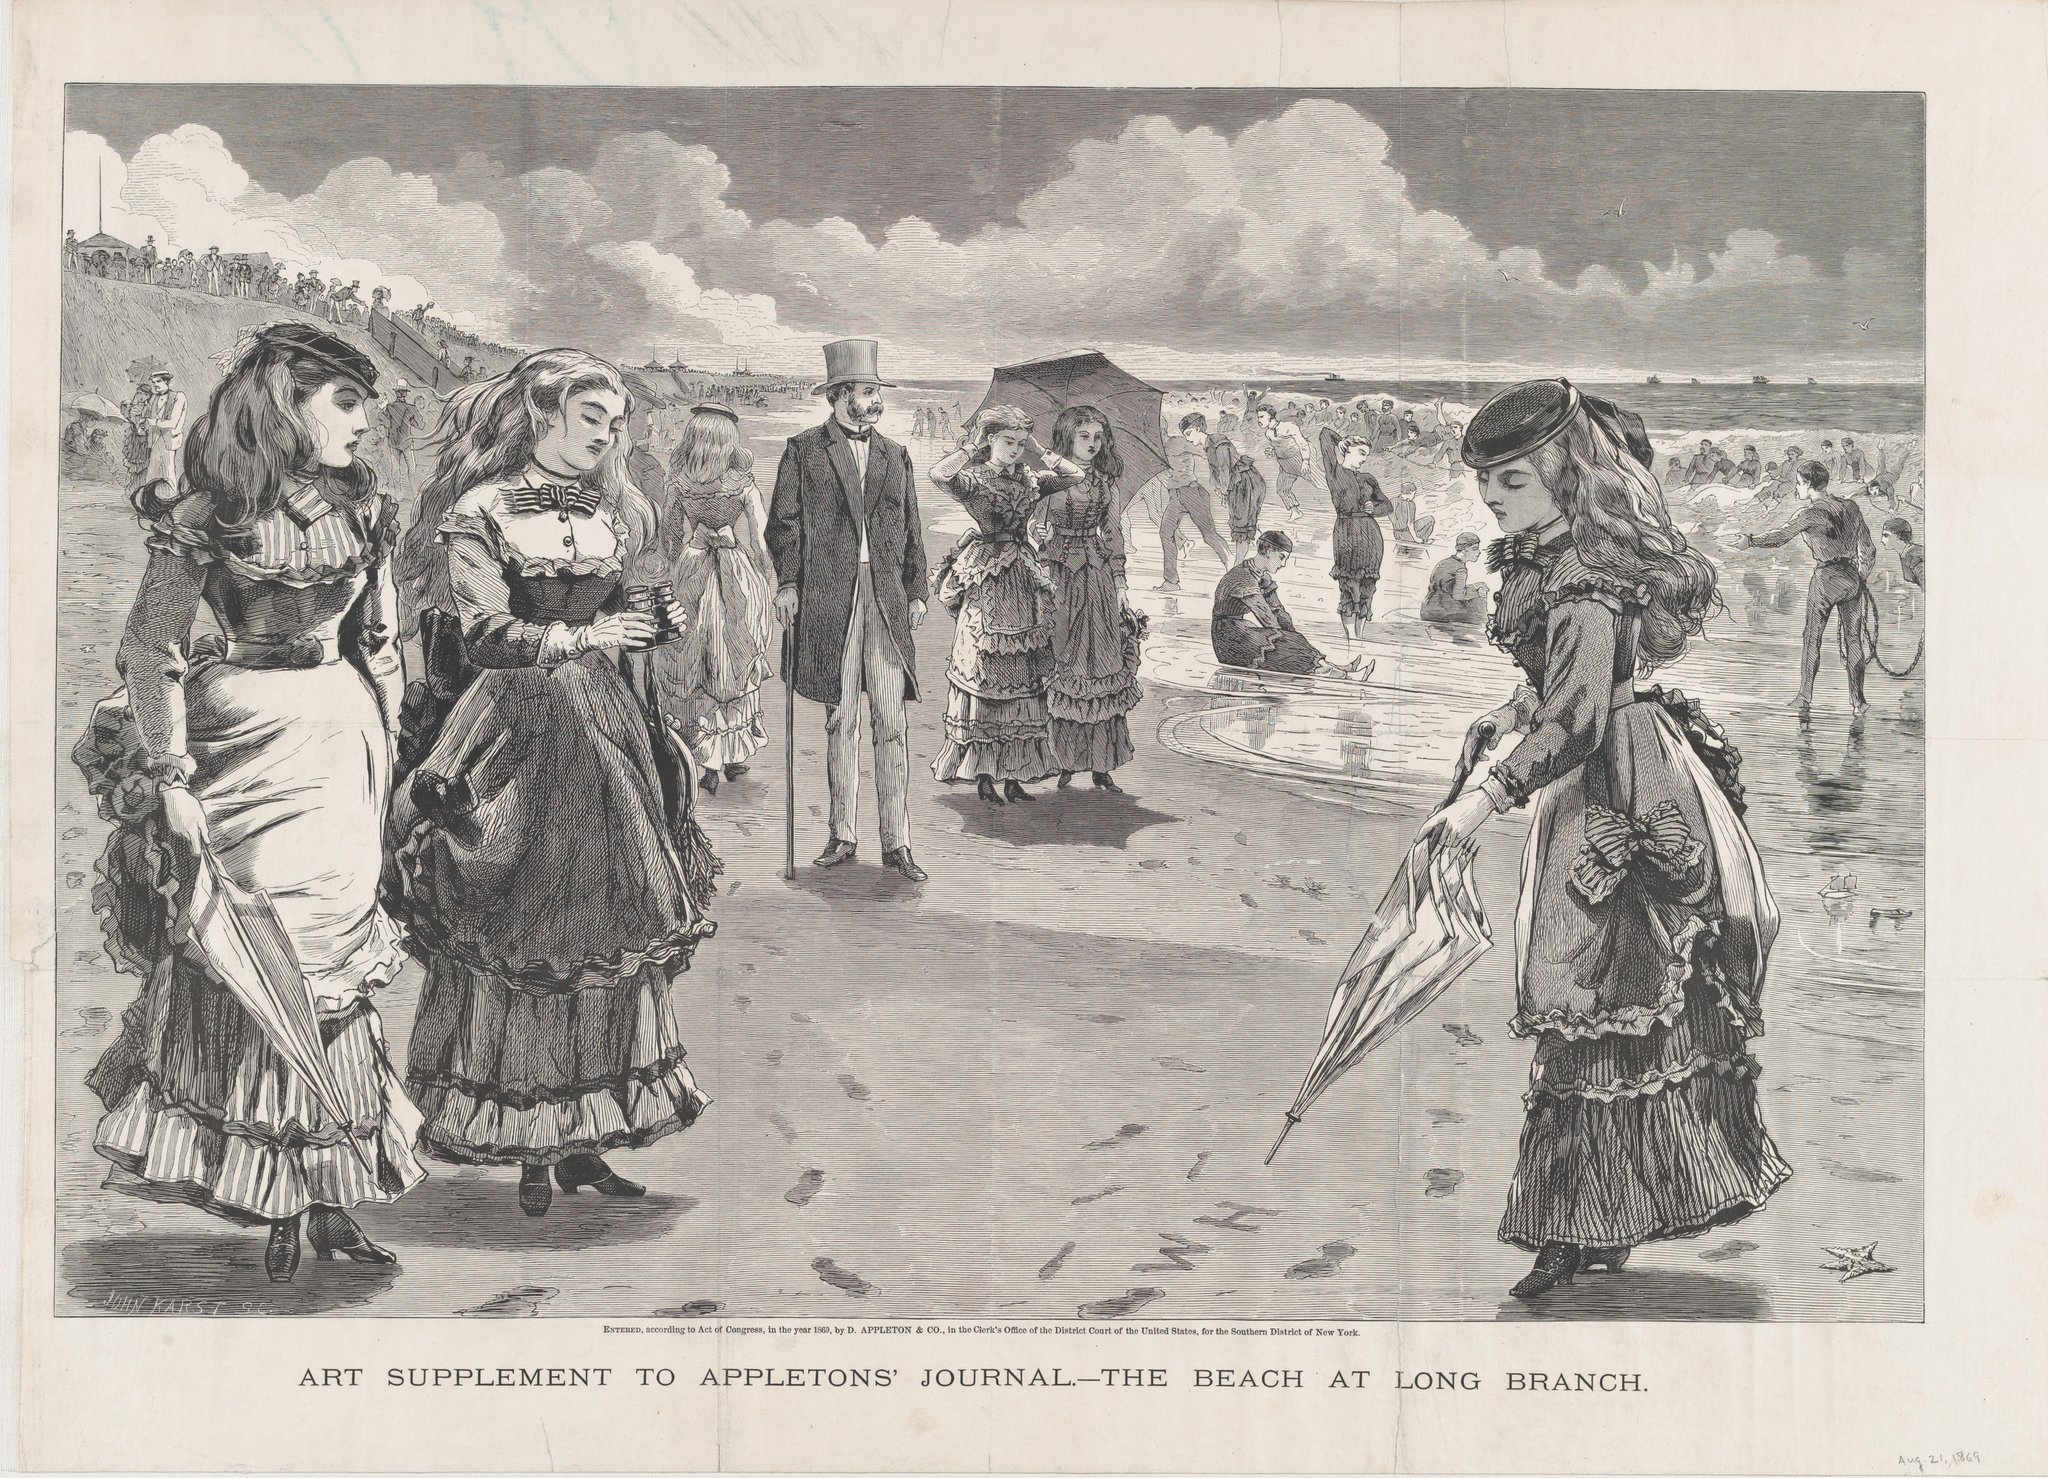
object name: print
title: The Beach at Long Branch (from "Appleton's Journal," Vol. II)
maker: winslow homer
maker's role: artist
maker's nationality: american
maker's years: 1836-1910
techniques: engraving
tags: men,women,beaches